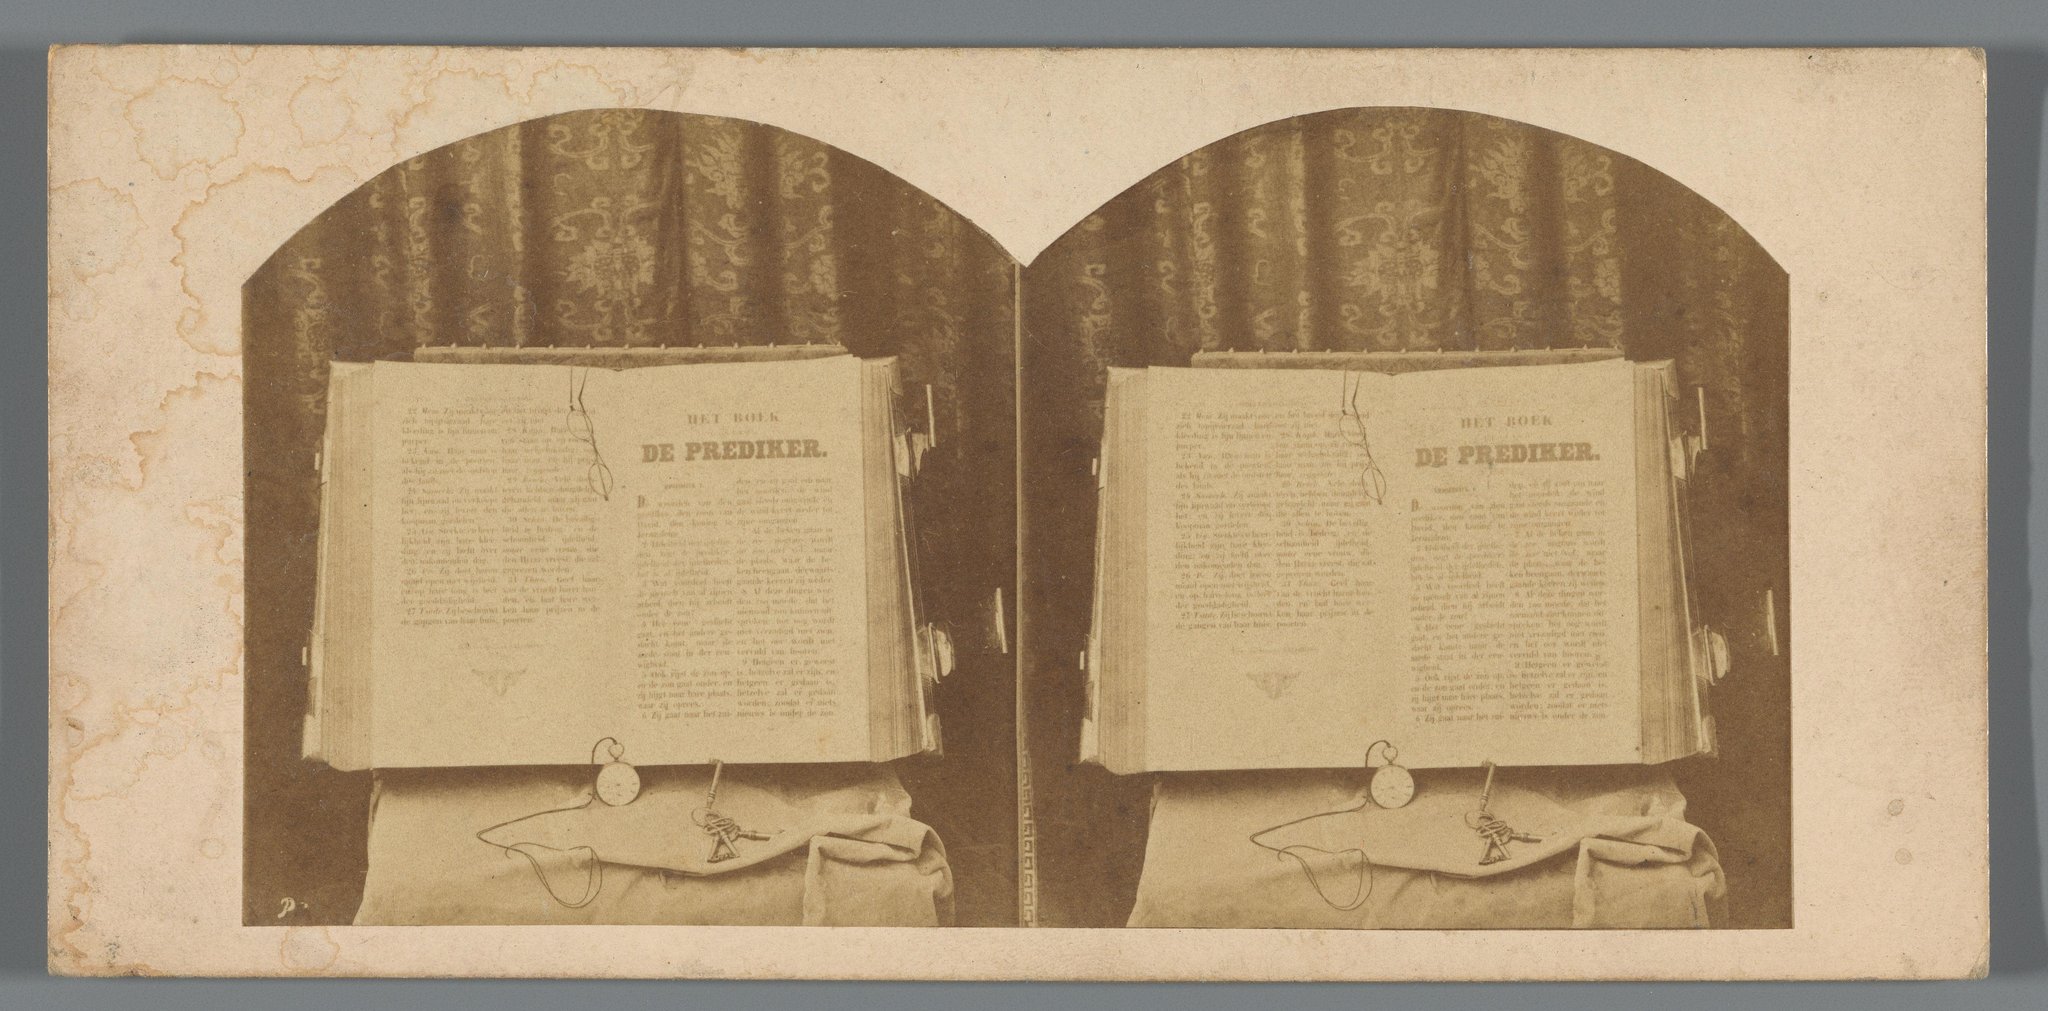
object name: stereograph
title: Stilleven met het boek Prediker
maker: Anonymous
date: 1857-1863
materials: cardboard, paper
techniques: albumen print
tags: still life of related objects